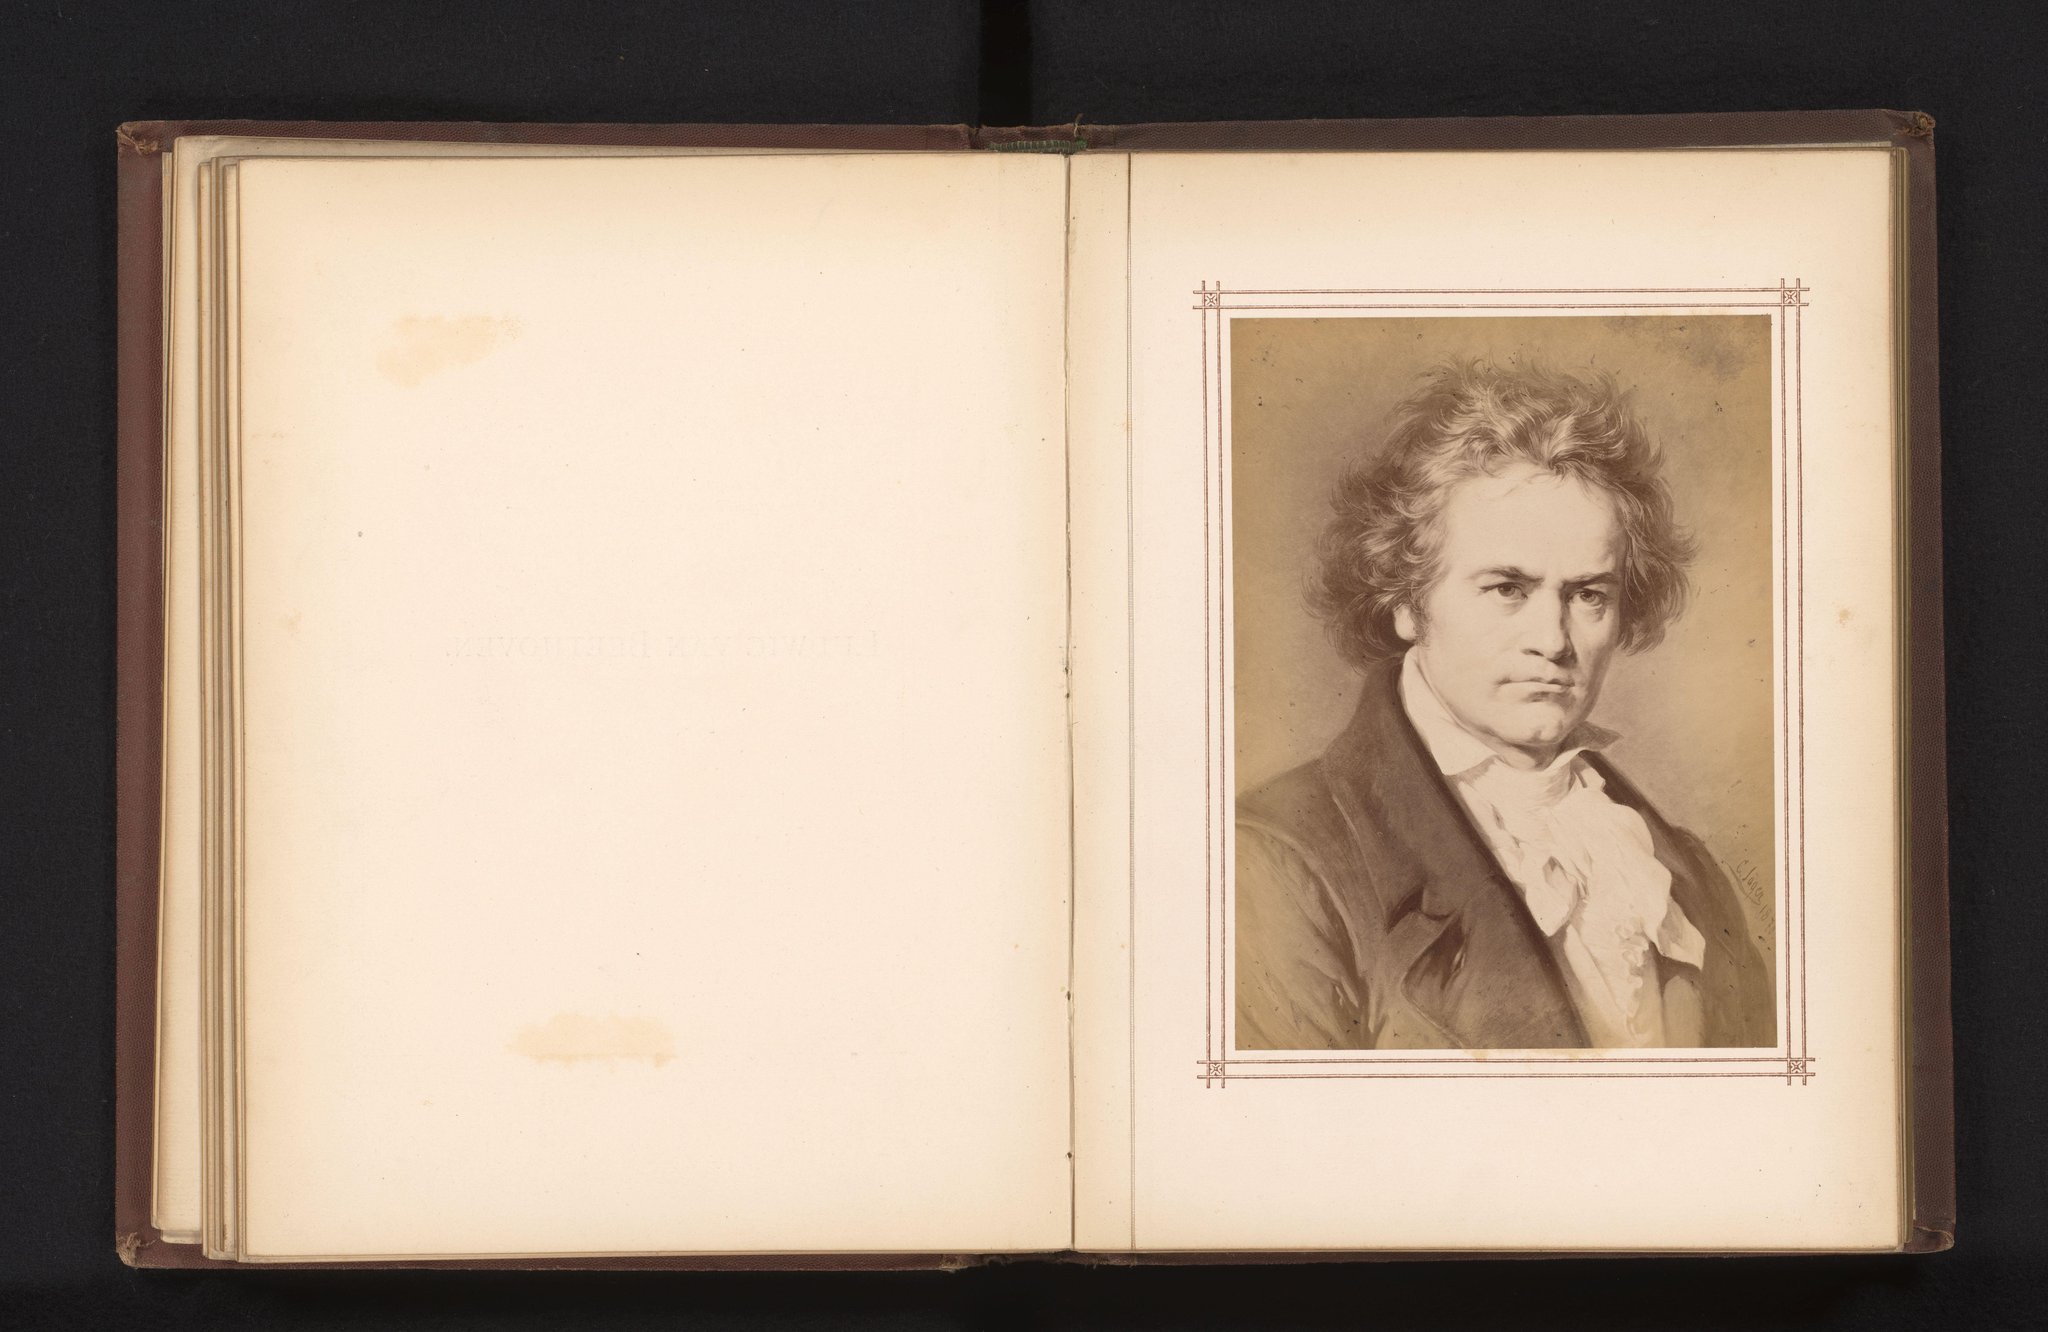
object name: reproduction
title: Fotoreproductie van een portret van Ludwig van Beethoven door Carl Jaeger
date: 1865-1875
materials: photographic support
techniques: albumen print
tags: vienna, composer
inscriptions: name: ‘C. Jäger 1870’